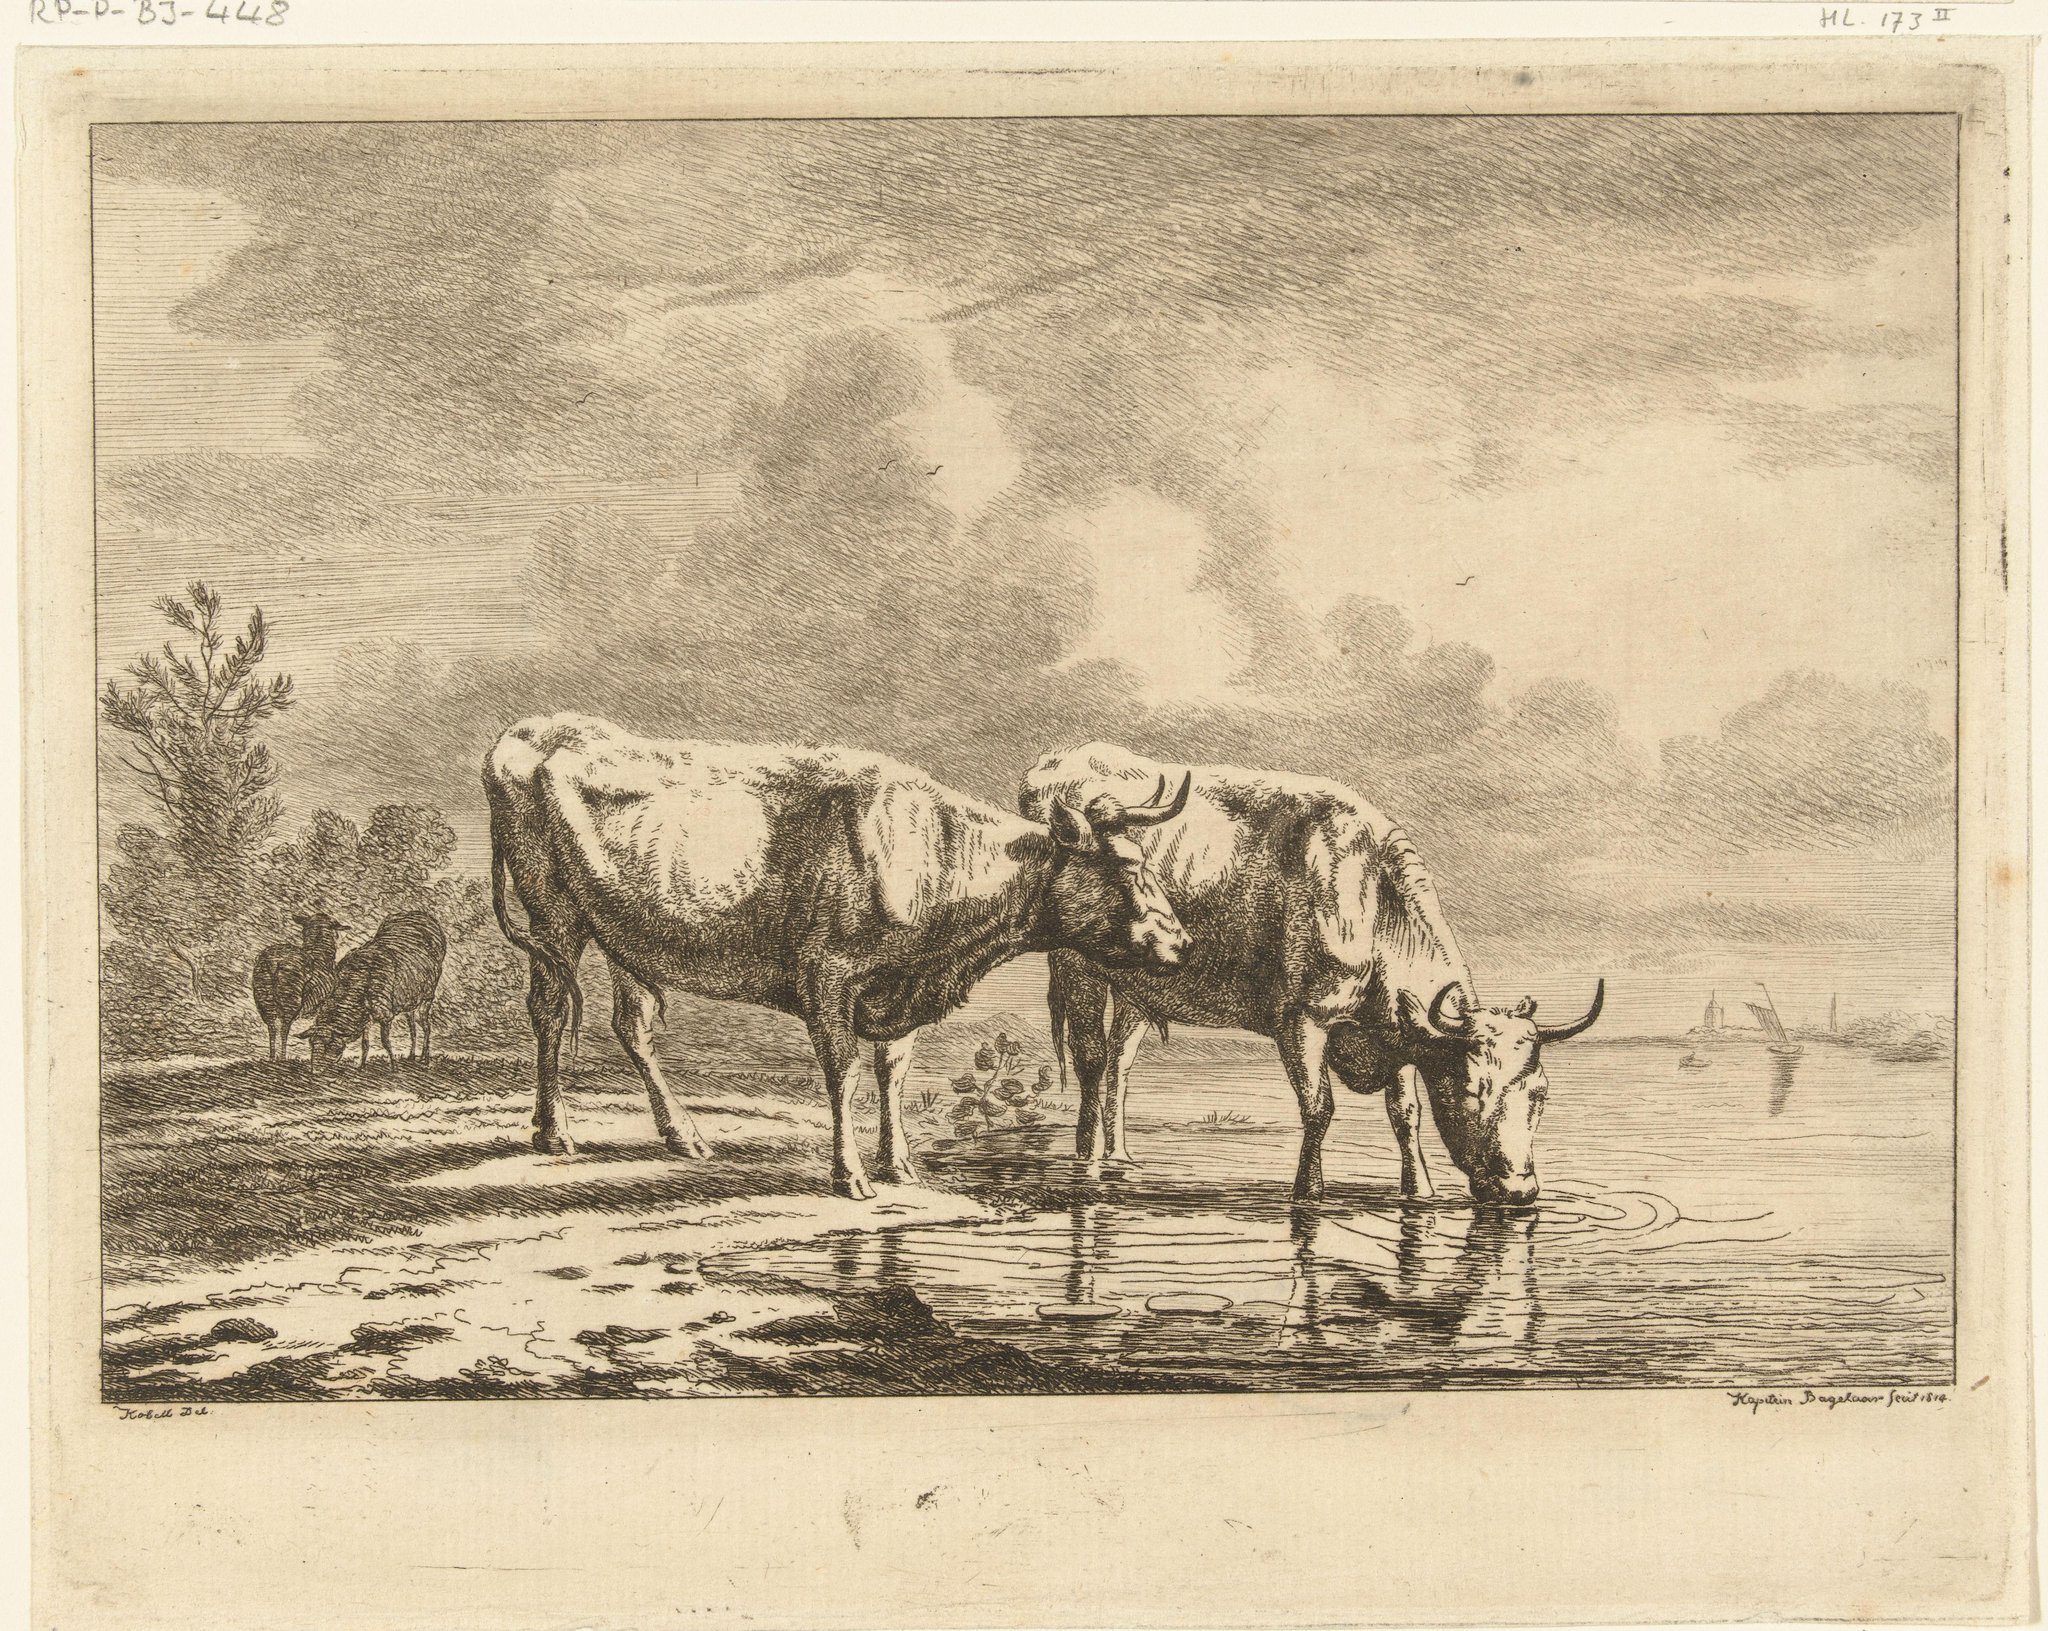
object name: print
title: Twee stieren en twee schapen bij het water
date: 1814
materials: paper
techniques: drypoint, etching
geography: netherlands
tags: sheep, bovine cattle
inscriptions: collector's mark: Lugt 2228